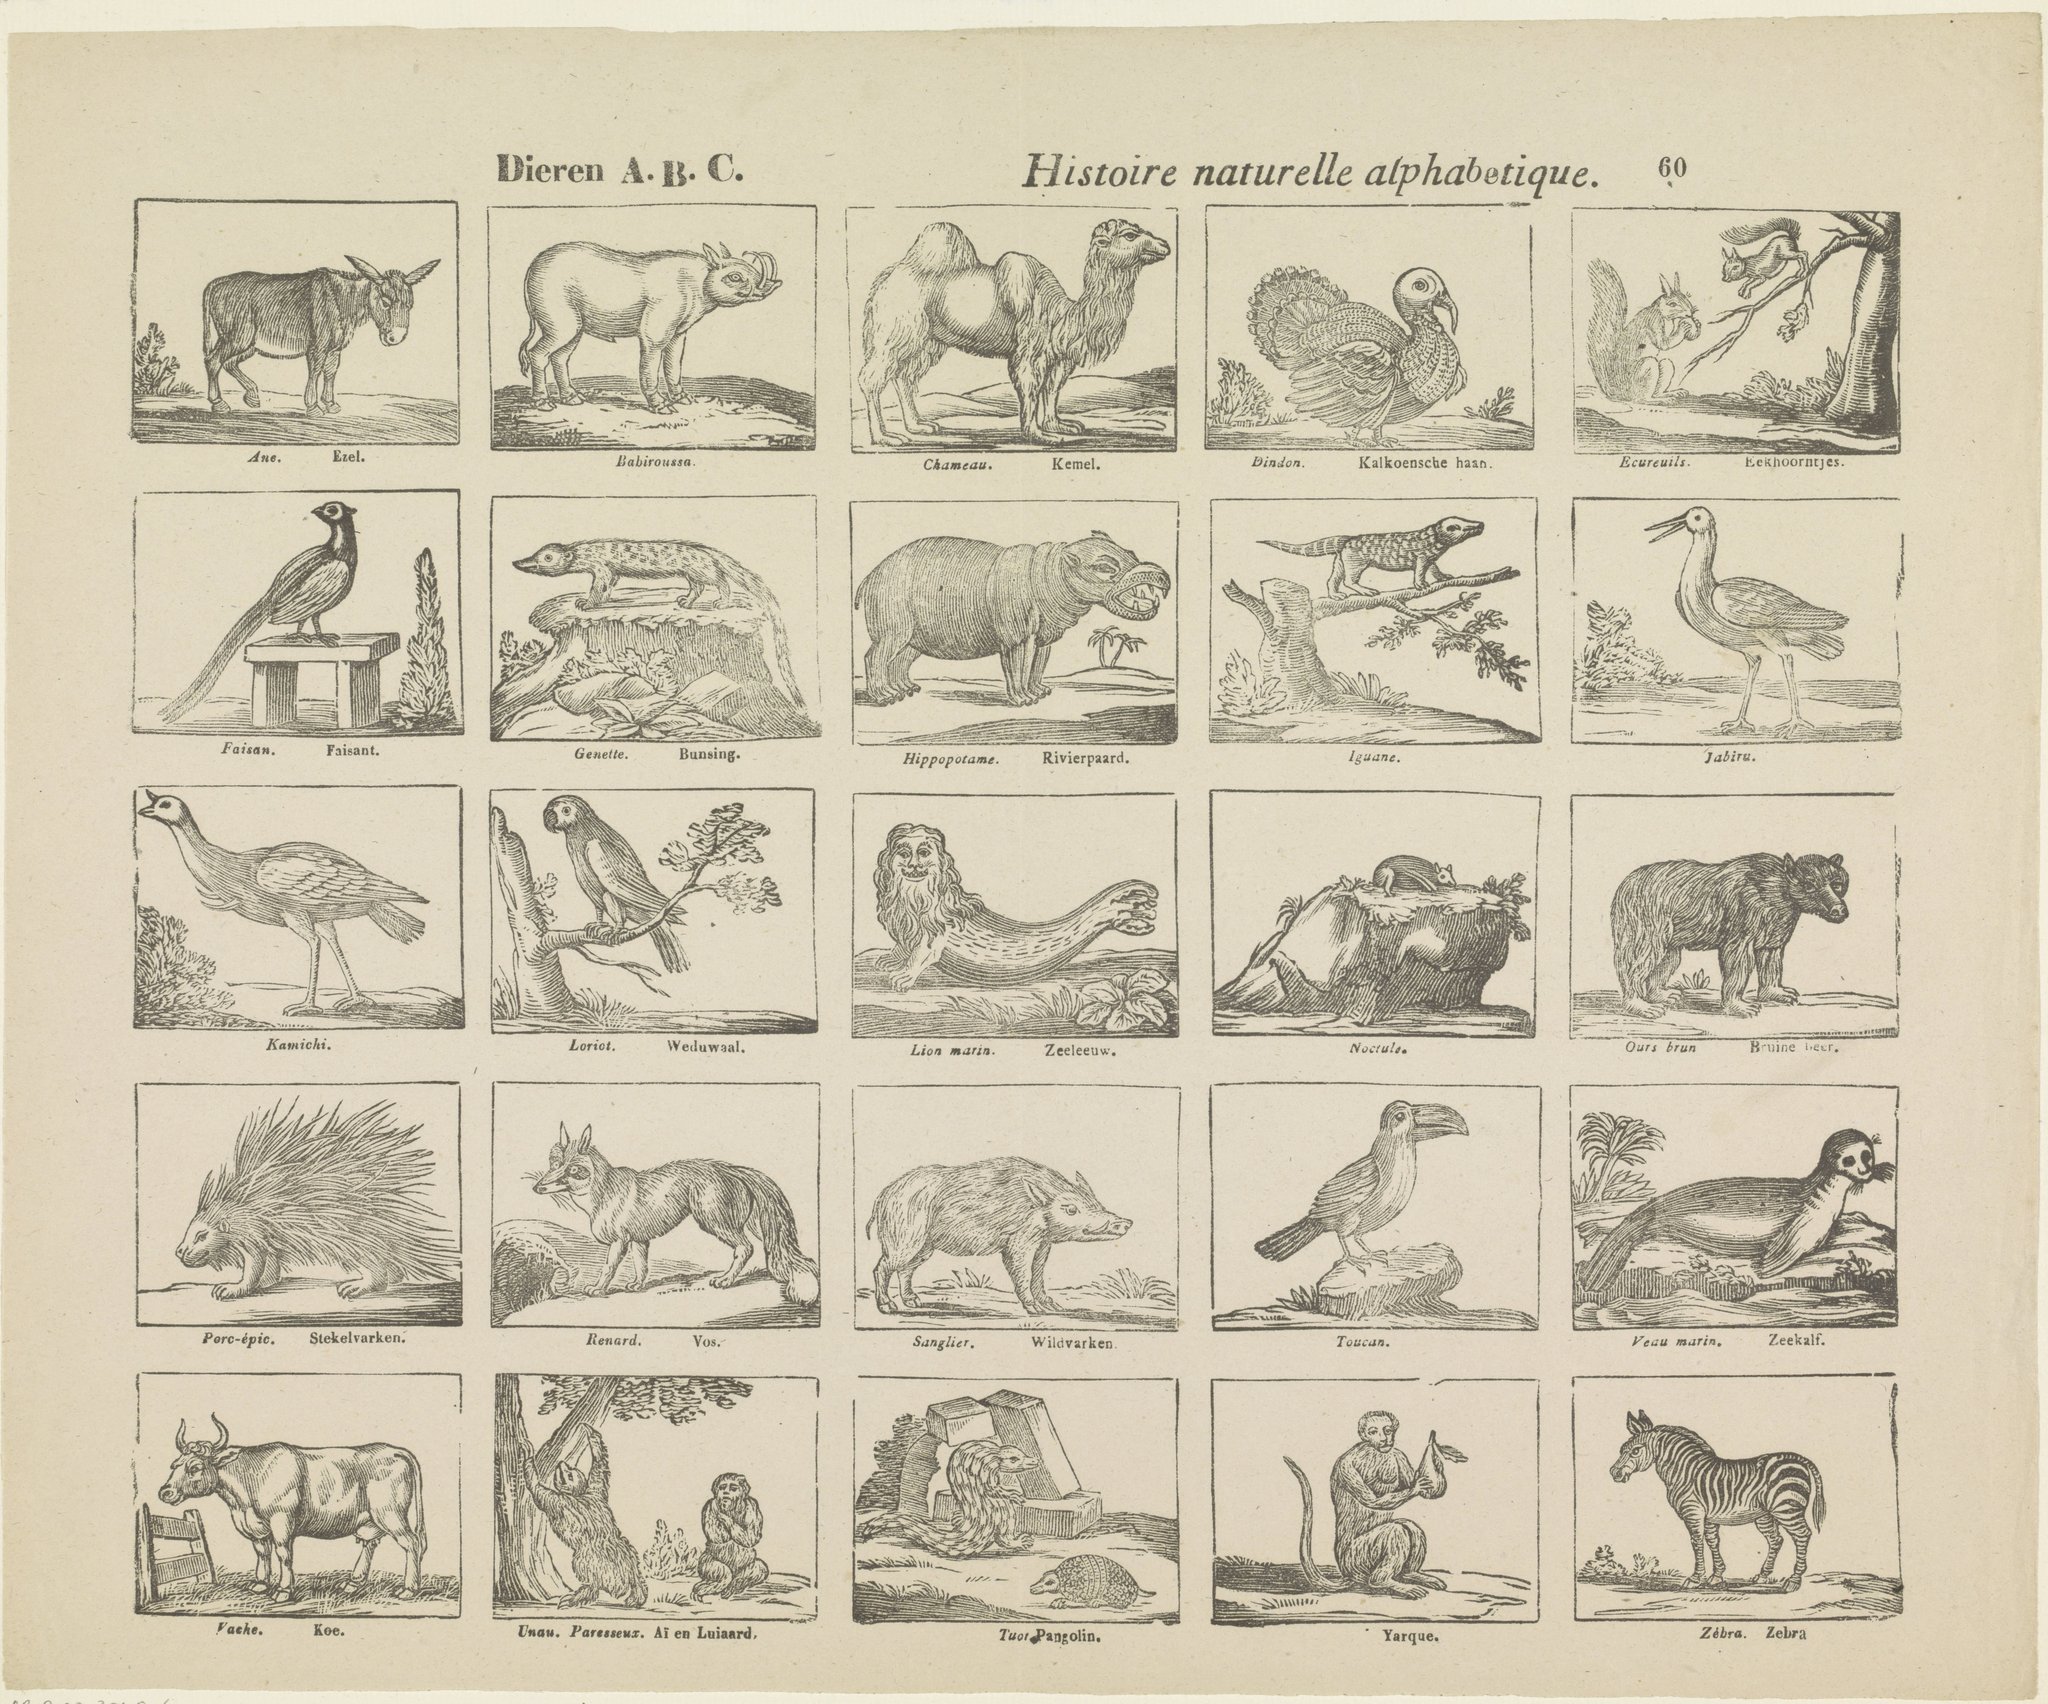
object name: popular print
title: Dieren A.B.C. / histoire naturelle alphabetique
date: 1800-1833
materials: paper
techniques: letterpress printing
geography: turnhout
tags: hoofed animals: camel, cow, hoofed animals: hippopotamus, animals, walker and runner birds: turkey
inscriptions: collector's mark: Lugt 2760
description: Blad met 25 voorstellingen van de letters van het alfabet geïllustreerd met dieren waarvan de woorden met de betreffende letter beginnen. Onder elke afbeelding een onderschrift in het Nederlands en in het Frans. Genummerd rechtsboven: 60.